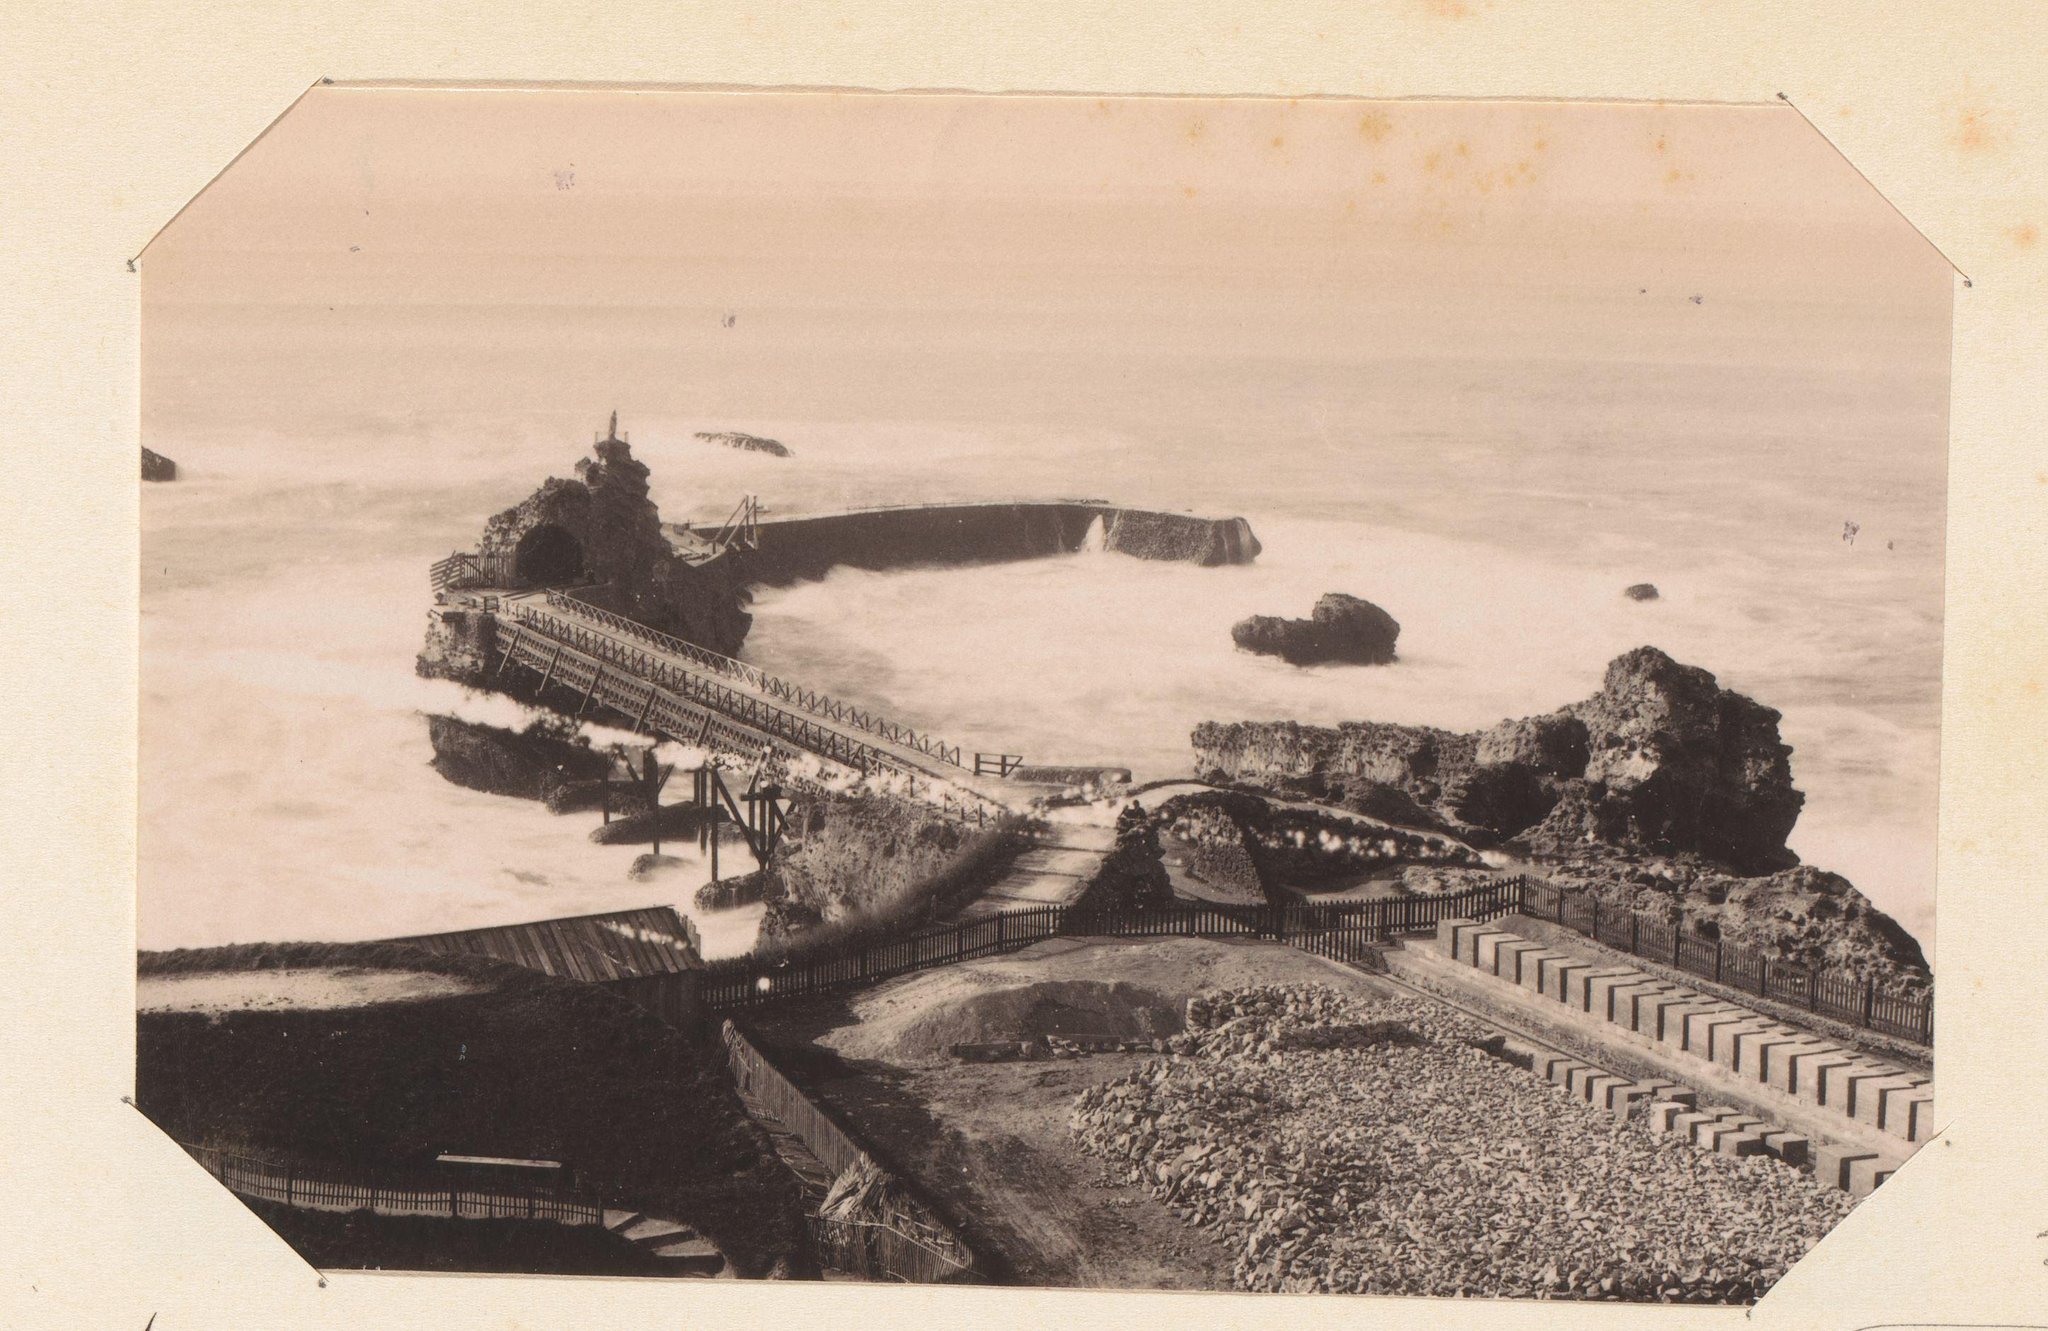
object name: album leaf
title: Gezicht op de pier en haven van Biarritz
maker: Anonymous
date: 1885-1892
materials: photographic support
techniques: albumen print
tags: harbour, pier, quay, wharf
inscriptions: annotation: ‘biarritz - haven’